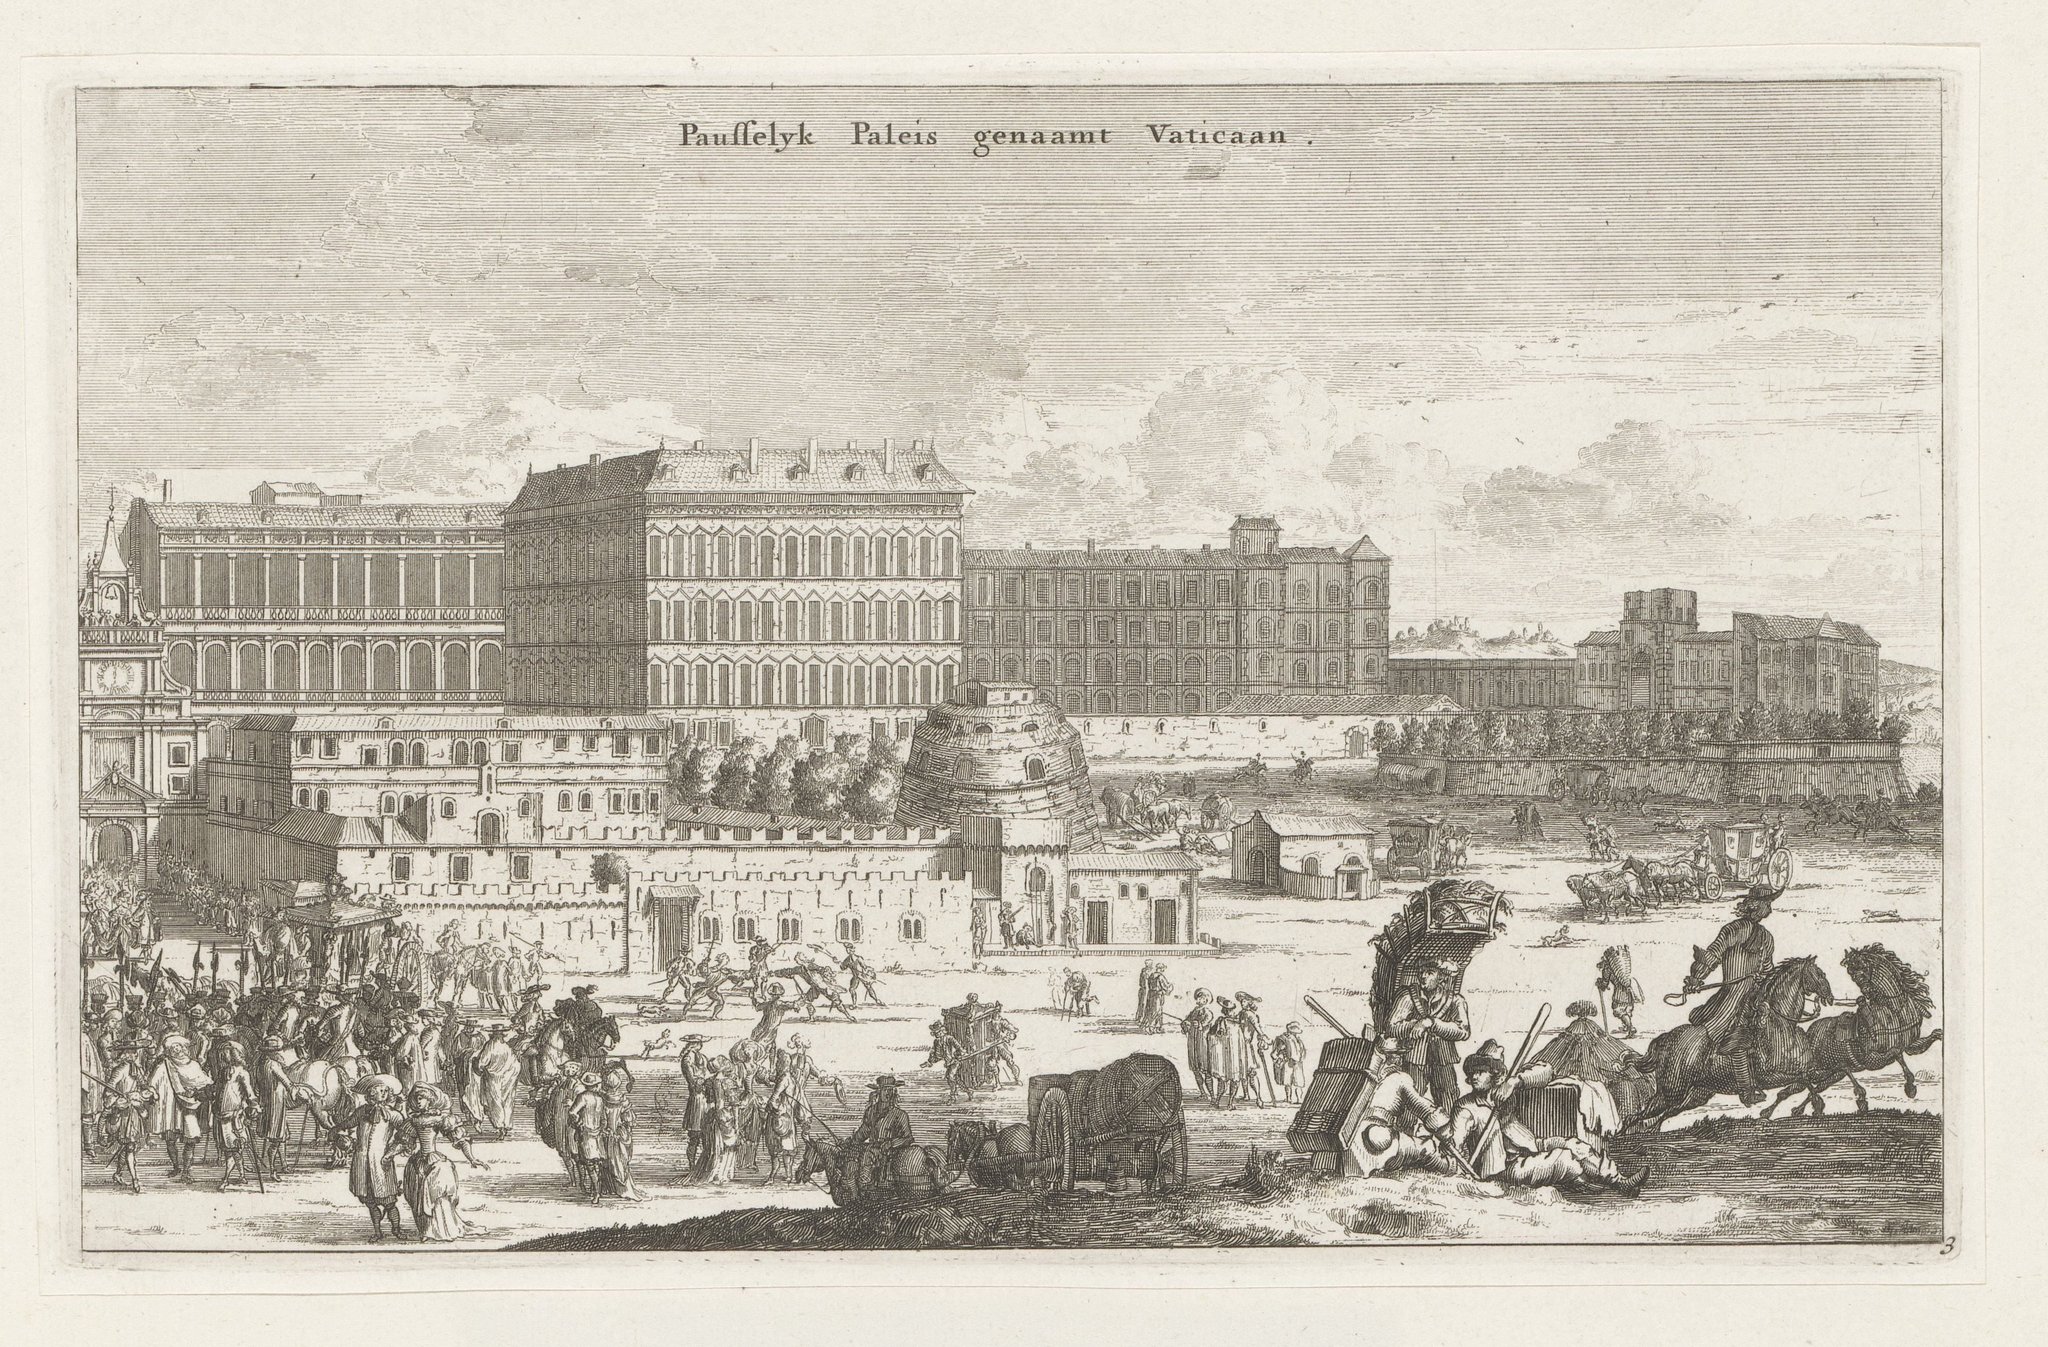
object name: album leaf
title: Apostolisch Paleis te Vaticaanstad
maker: willem swidde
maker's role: print maker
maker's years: 1660-1697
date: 1670-1697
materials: paper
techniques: etching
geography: netherlands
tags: palace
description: Genummerd rechtsonder: 3. De prent maakt deel uit van een album.